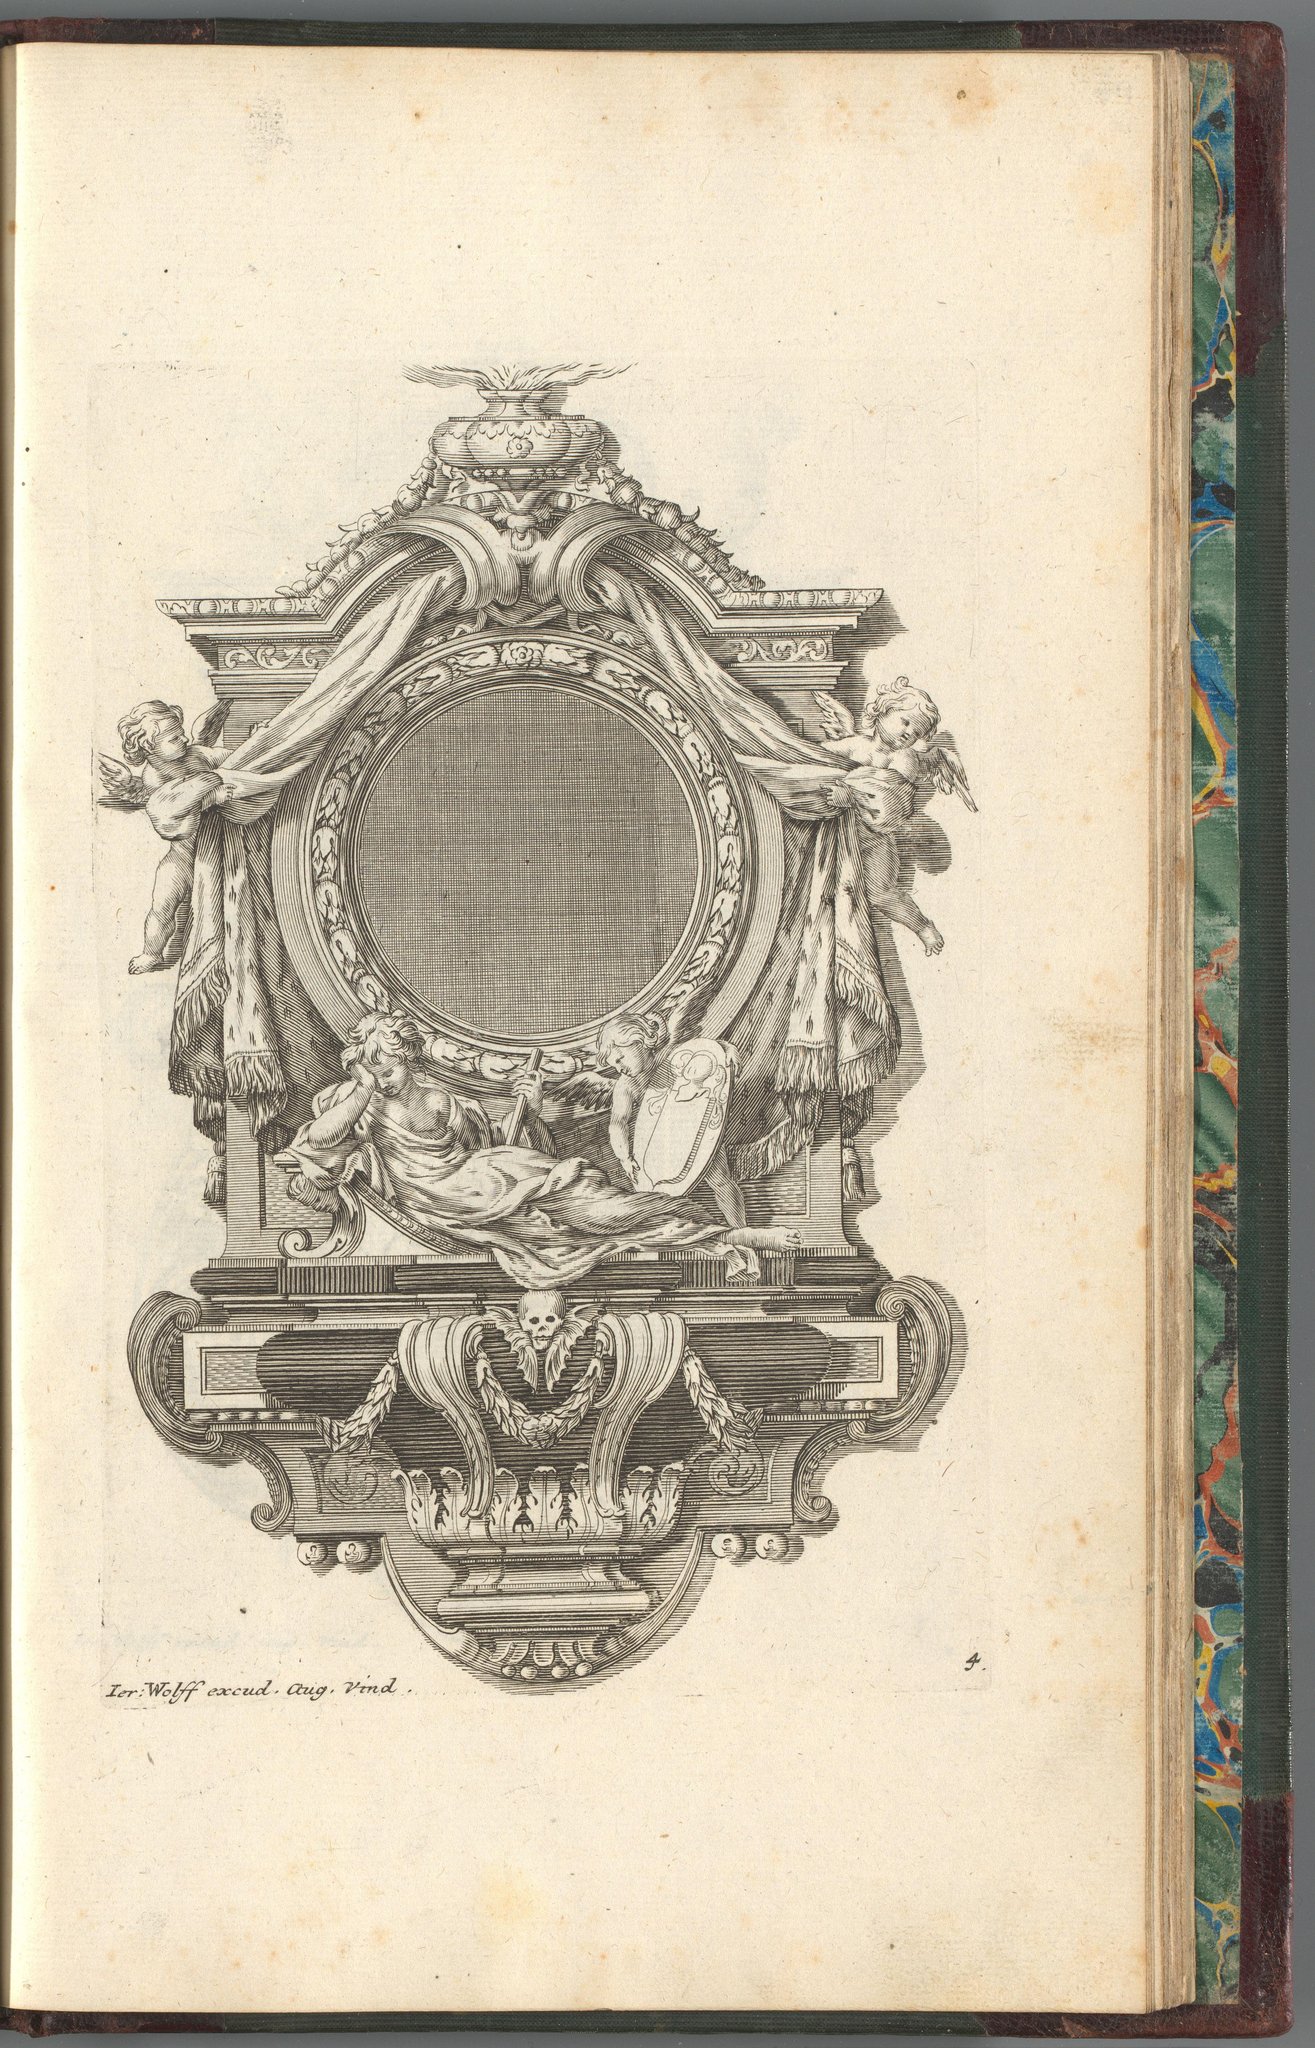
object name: print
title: Epitaaf met leeg medaillon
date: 1686-1724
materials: paper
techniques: engraving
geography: augsburg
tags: ornaments ~ art, epitaph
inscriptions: number: ‘4.’, signature: ‘Ier. Wolff excud. Aug. Vind.’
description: Een epitaaf met een leeg medaillon, daaronder ligt een rouwende jonge vrouw. Prent afkomstig uit een serie van zeven grafschriften. Prent maakt deel uit van een album. Gespiegelde kopie naar Frans origineel.